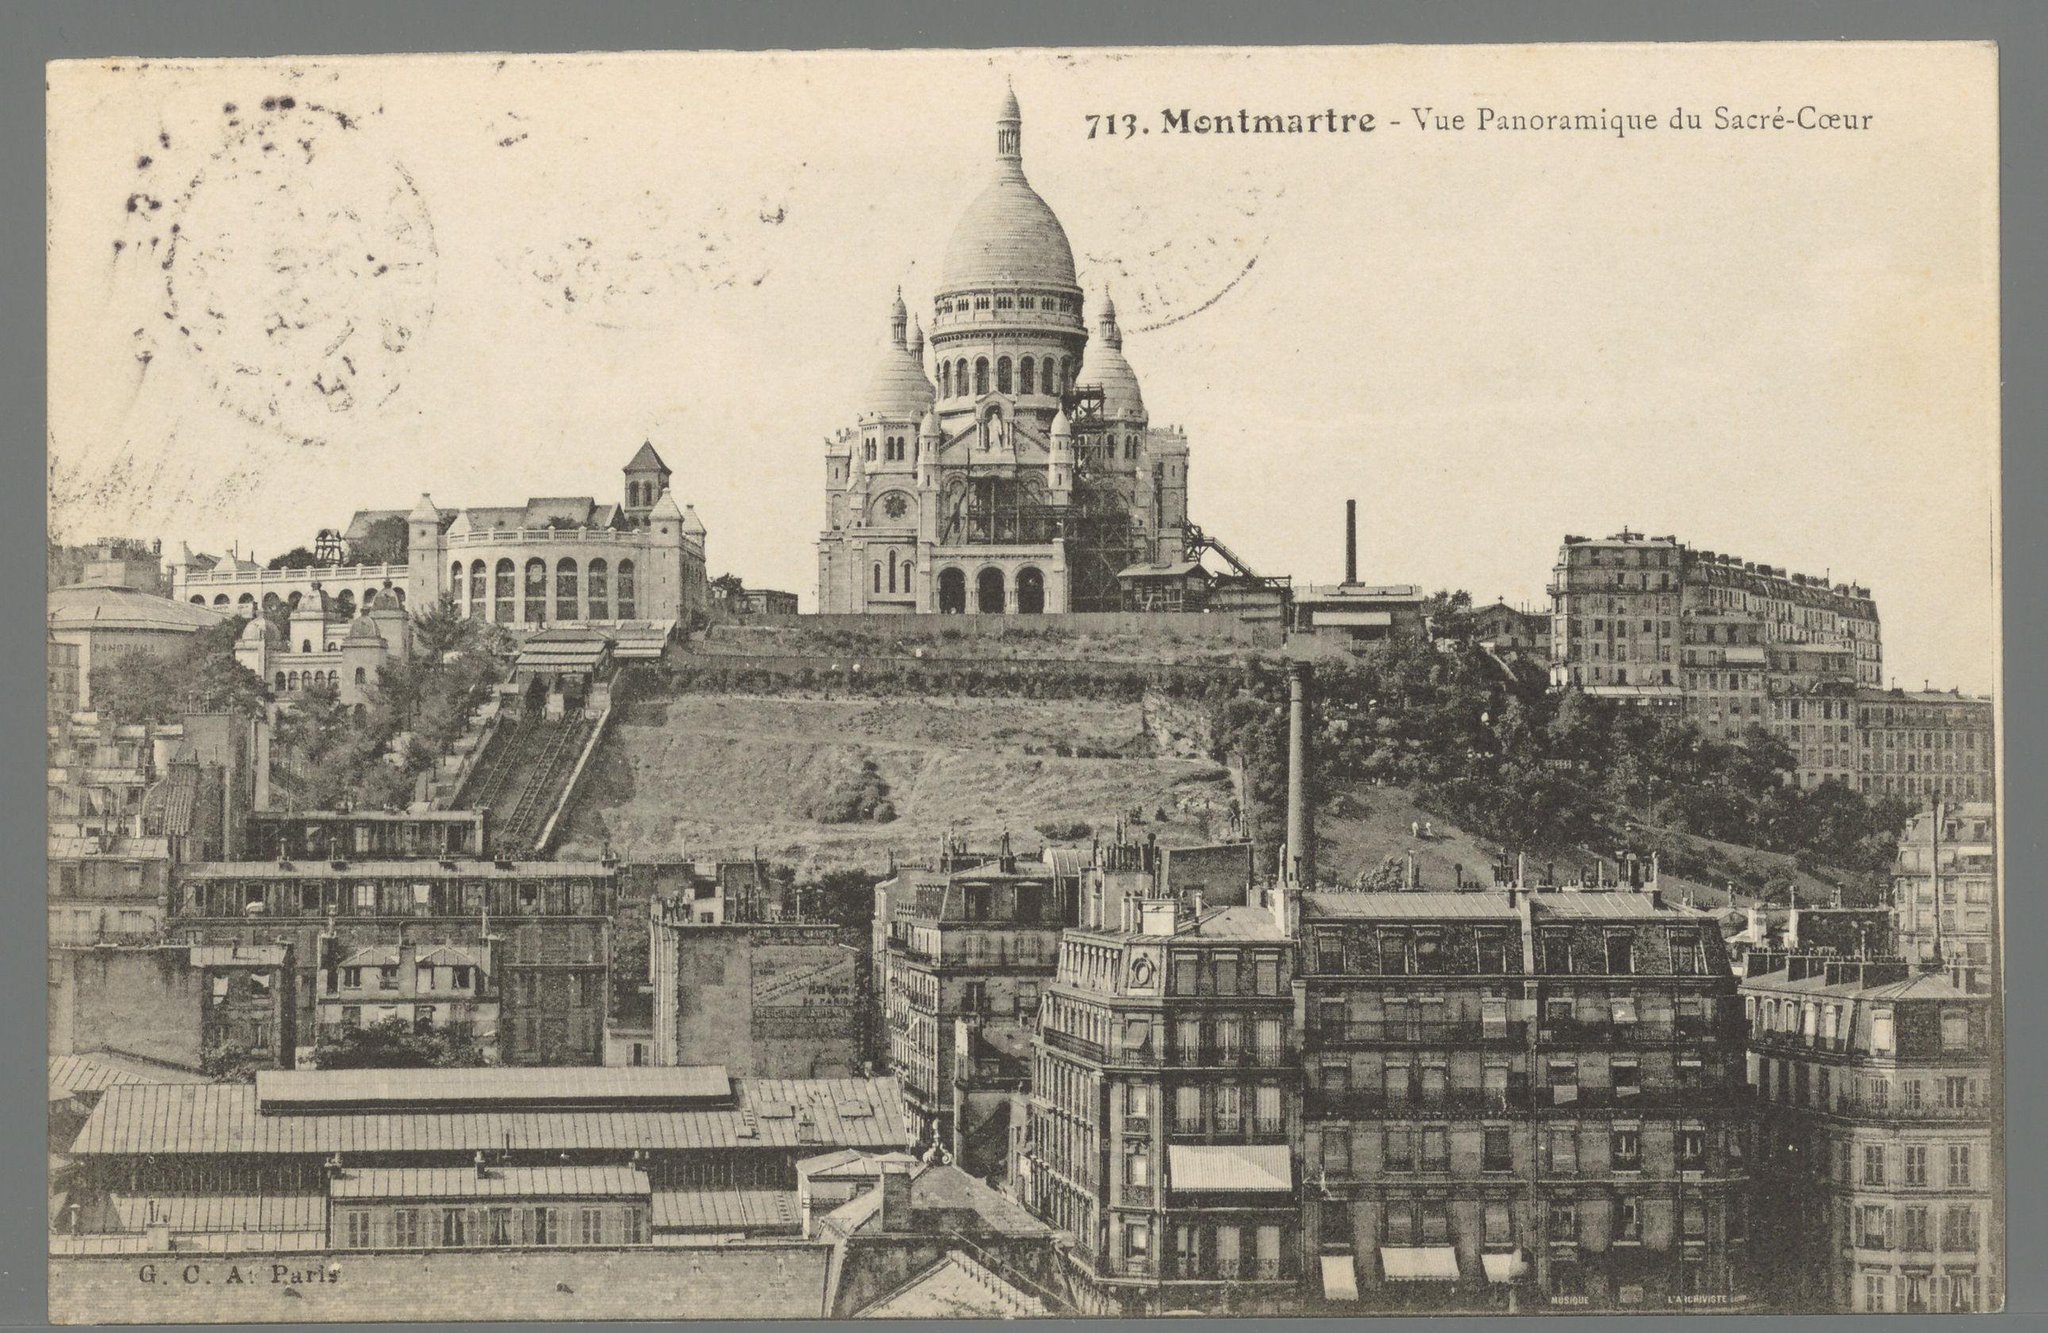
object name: ansichtkaart, prentbriefkaart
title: Montmartre. Vue Panoramique du Sacré-Coeur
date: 1903-1908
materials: cardboard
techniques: photograph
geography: paris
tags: city-view, and landscape with man-made constructions, church (exterior)